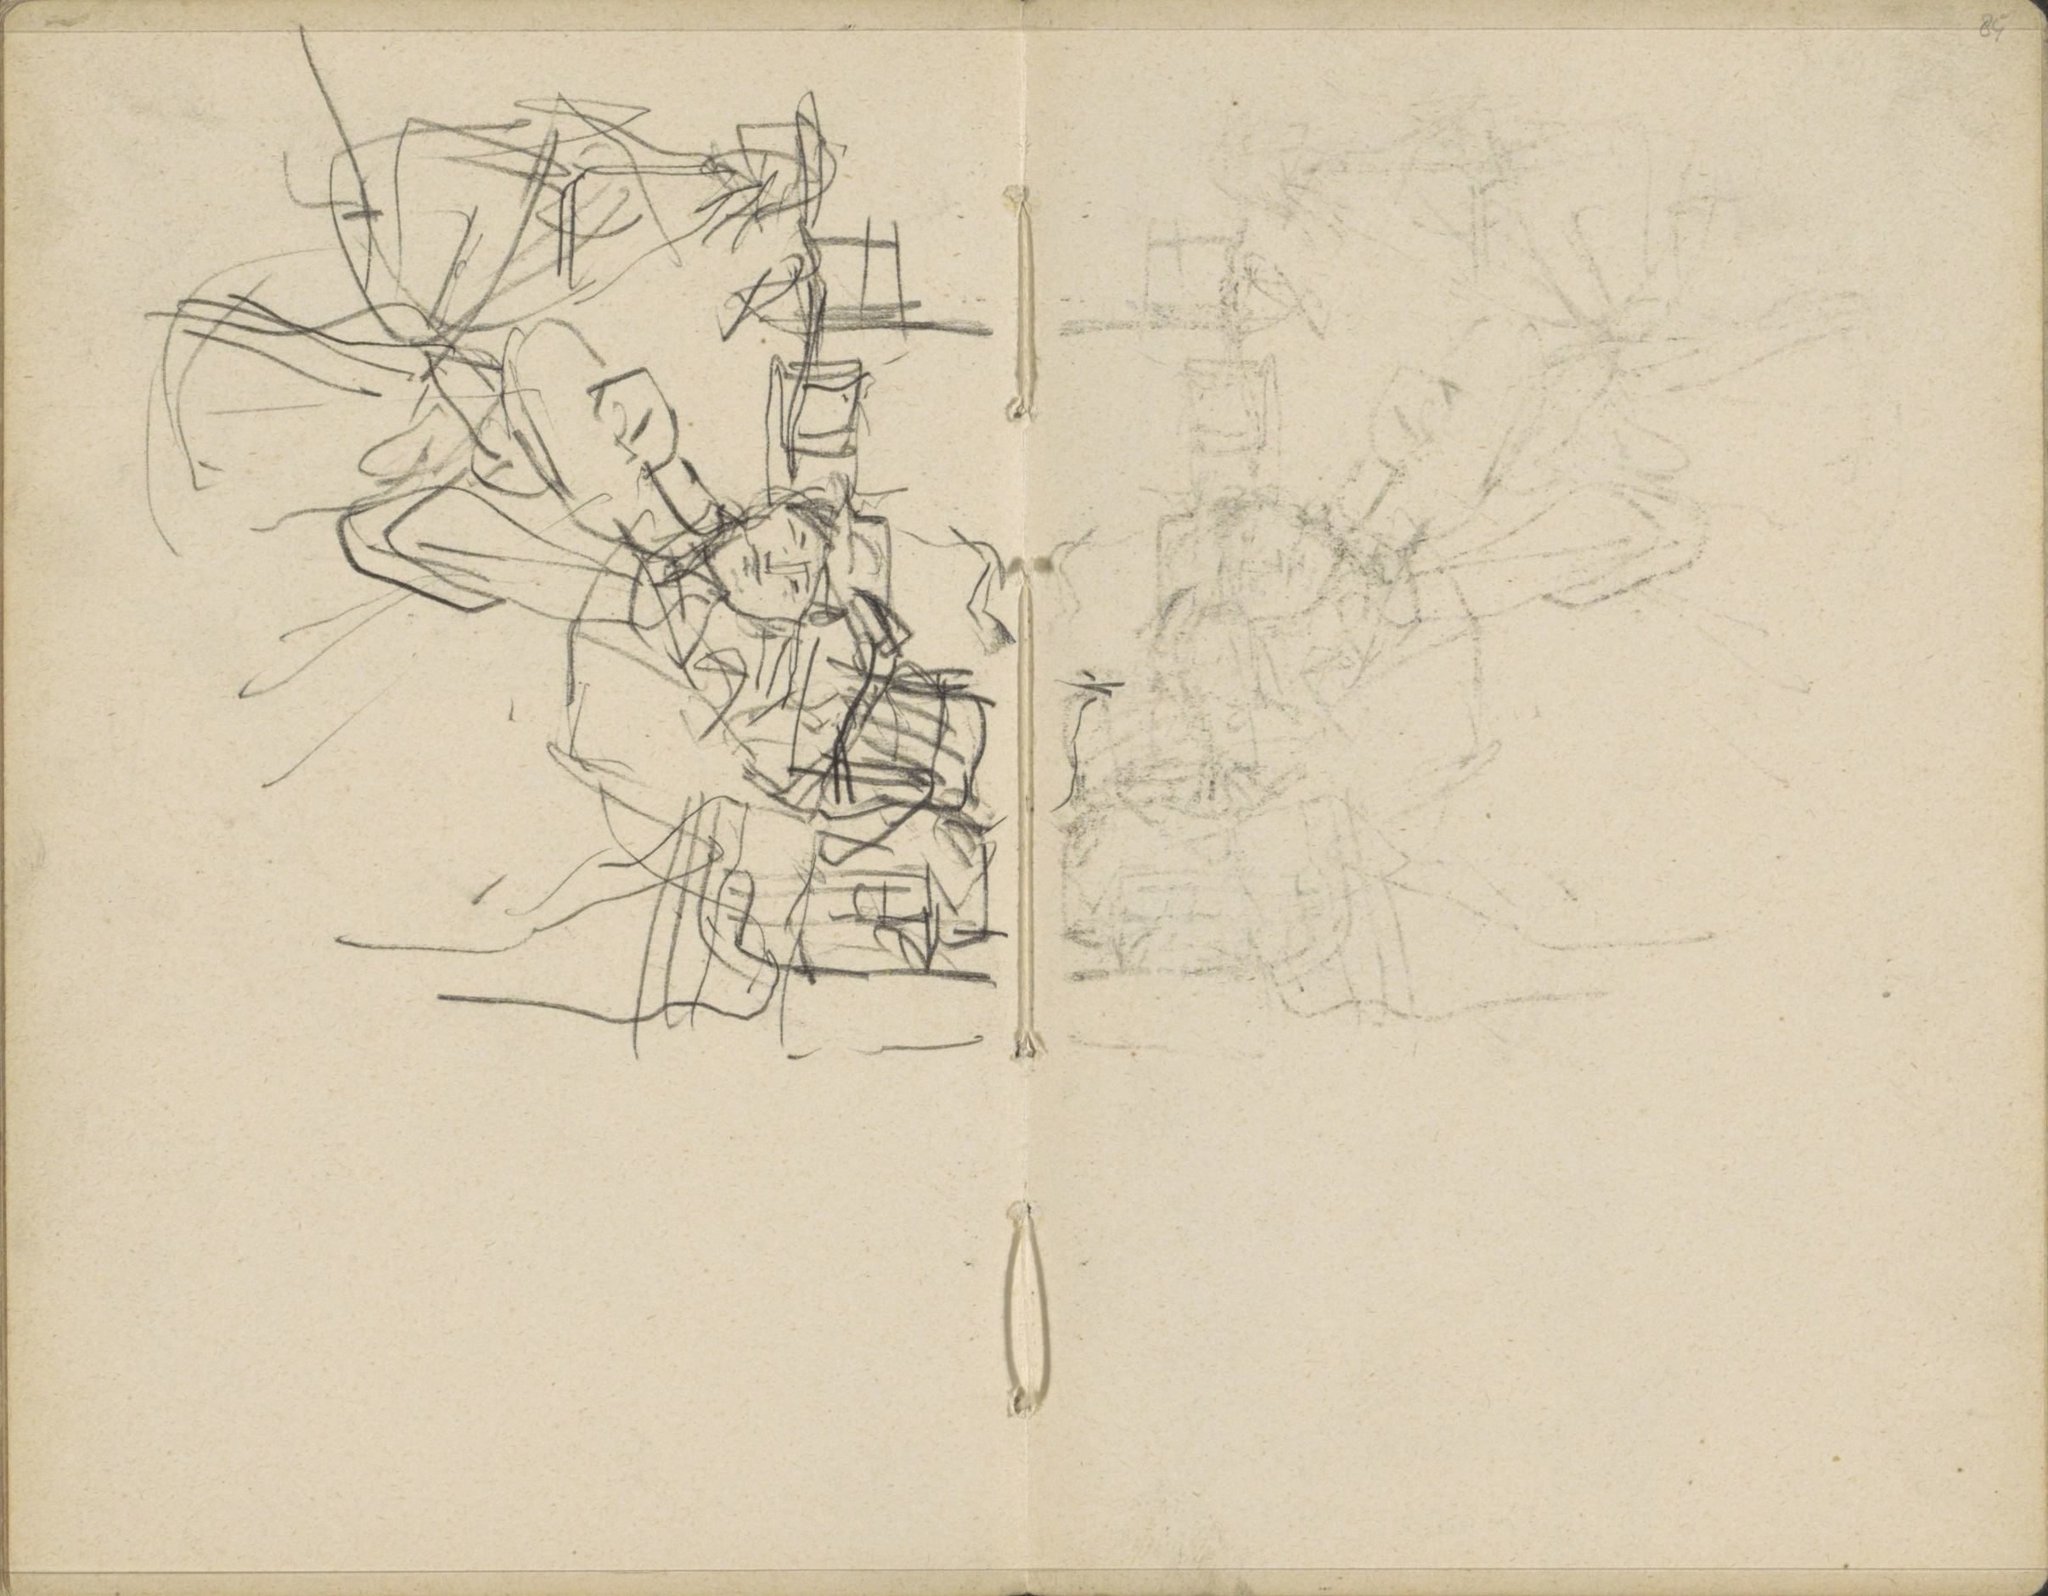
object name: sketchbook leaf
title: Figuren, mogelijk in een straat in Amsterdam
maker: george hendrik breitner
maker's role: draughtsman, painter, print maker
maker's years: 1857-1923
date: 1902-1914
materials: chalk, paper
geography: amsterdam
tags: urban housing, street (+ city(-scape) with figures, staffage)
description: Figuren, mogelijk in een straat in Amsterdam. Pagina 83 en pagina 84 uit een schetsboek met 46 bladen vervaardigd te Noord-Holland en Utrecht.